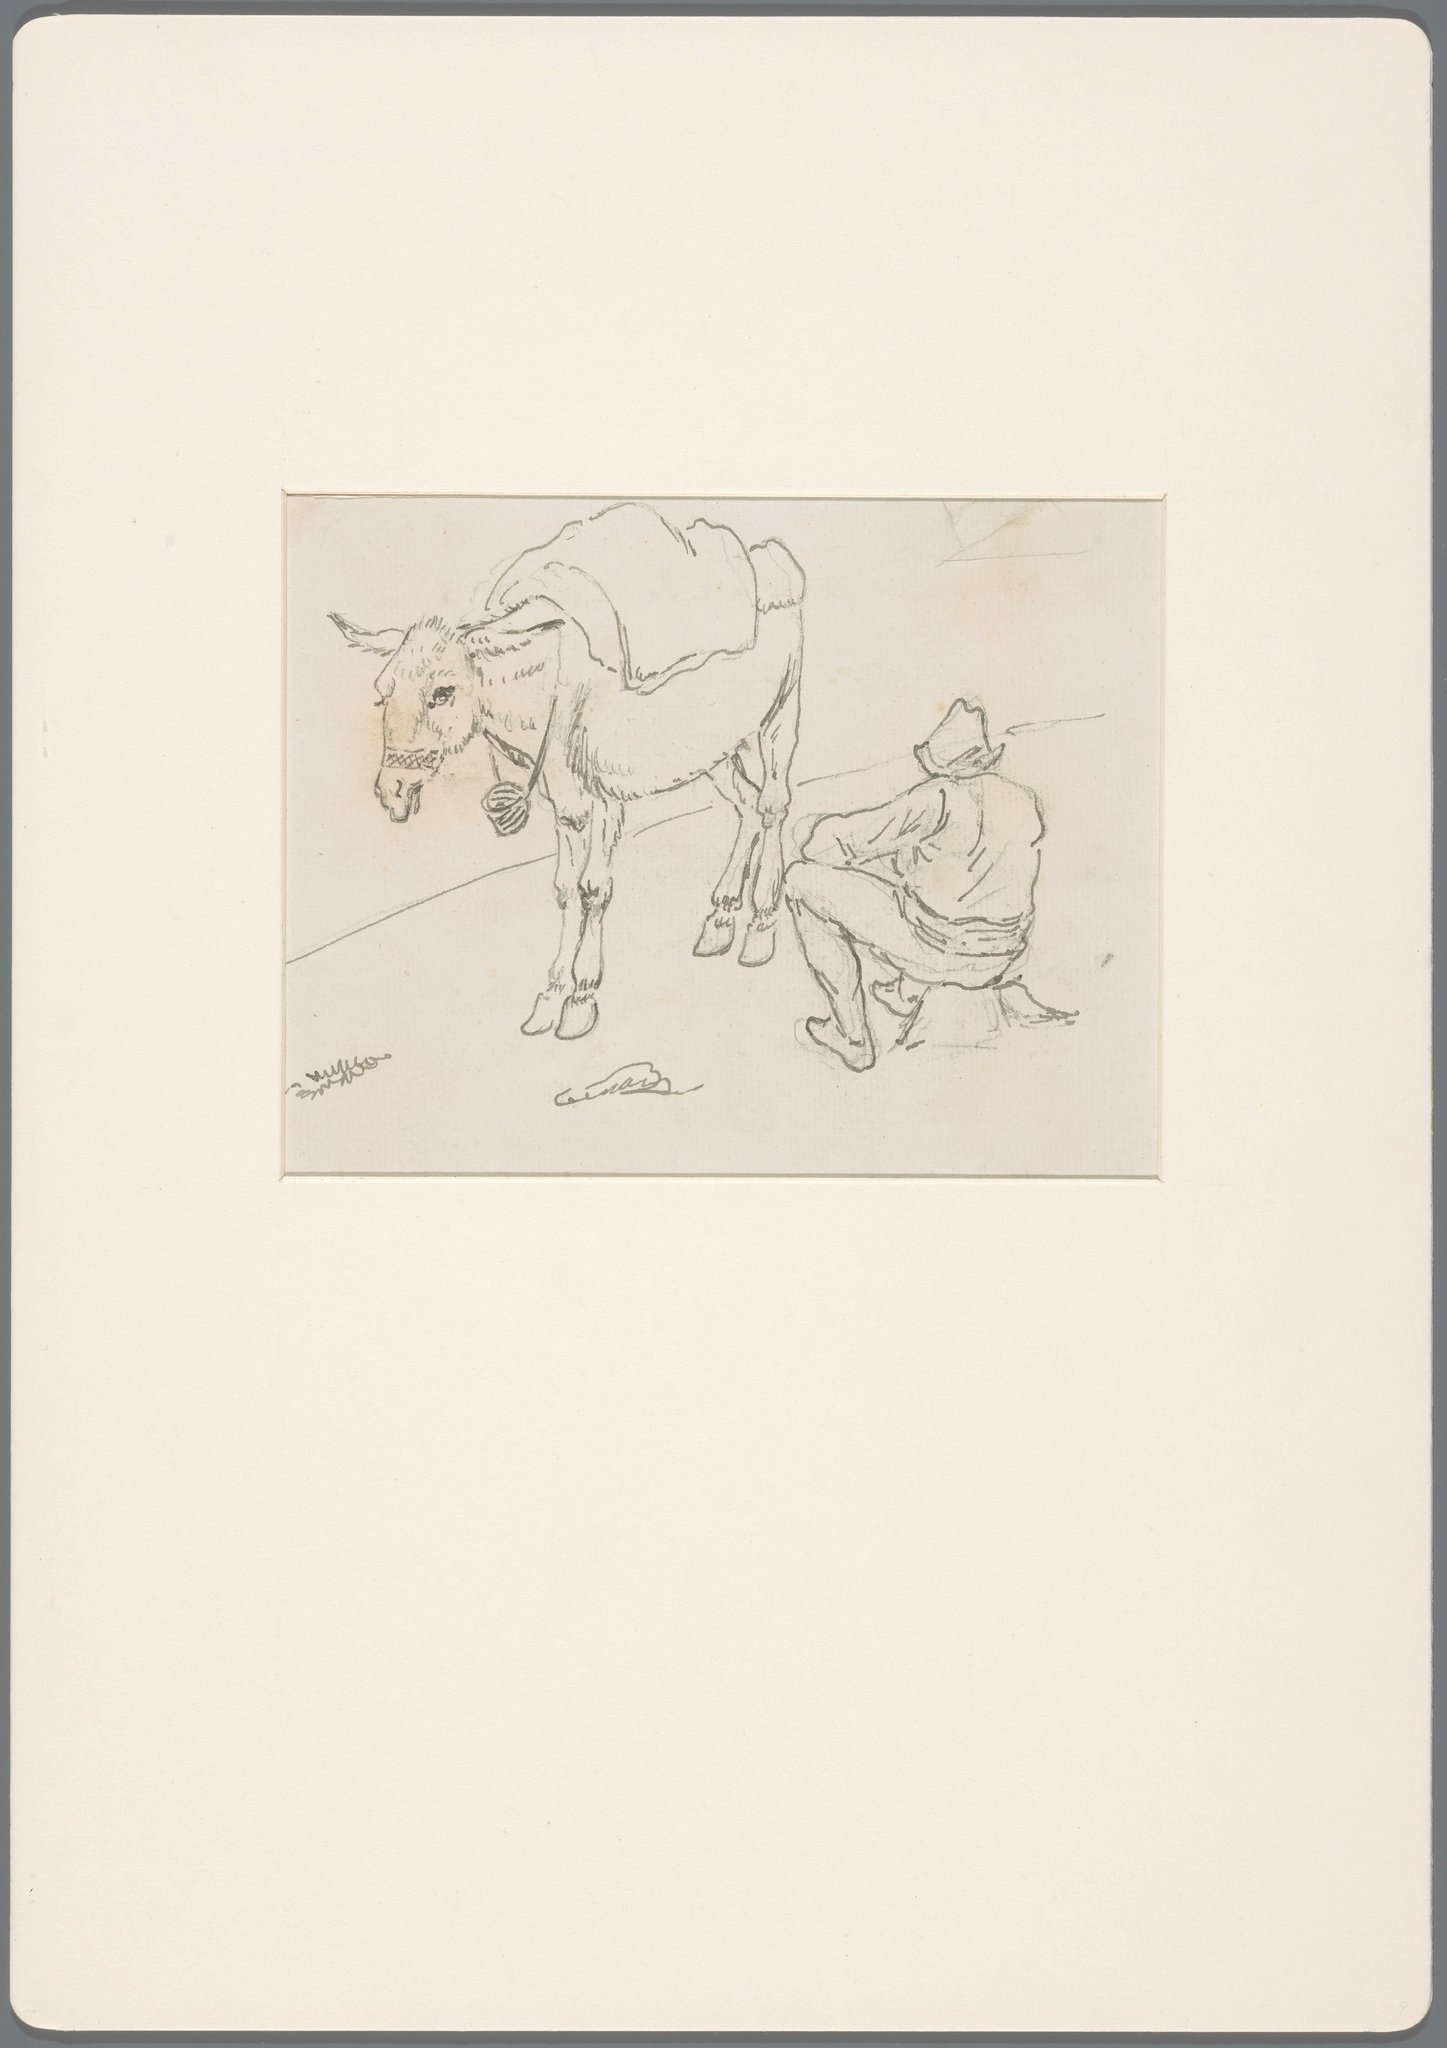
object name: drawing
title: Zittende man bij een ezel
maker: david alphonse de sandoz-rollin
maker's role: draughtsman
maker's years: 1740-1809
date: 1750-1809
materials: chalk, ink, paper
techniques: pen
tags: ass, donkey